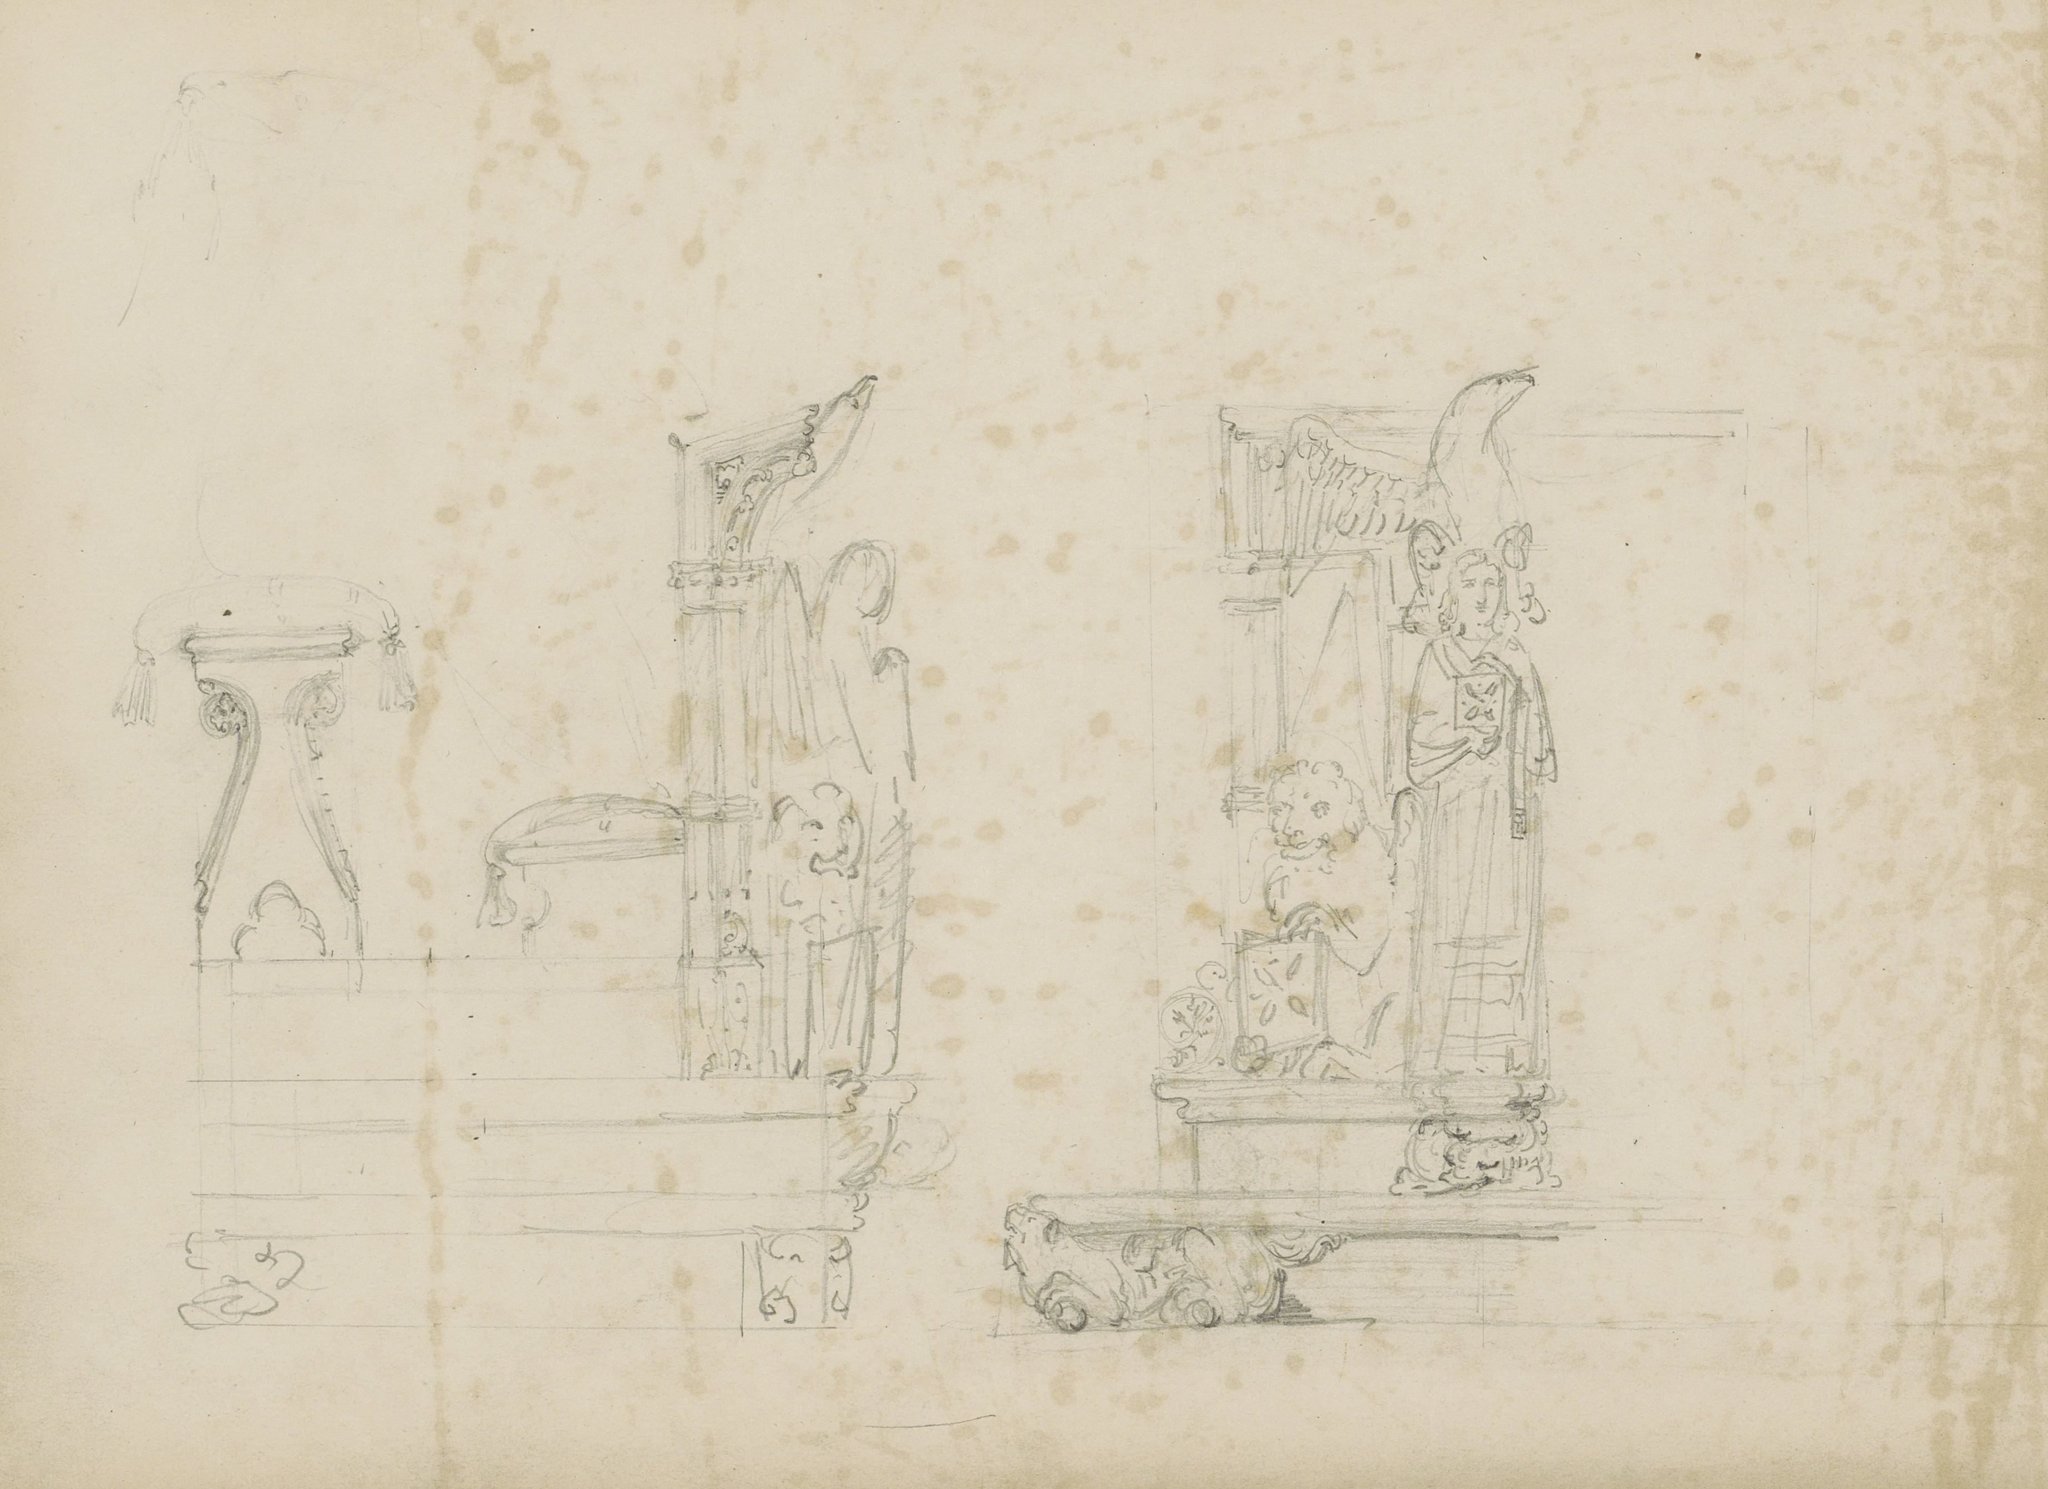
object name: sketchbook leaf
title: Spreekgestoelte, Grave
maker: pierre joseph hubert cuypers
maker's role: draughtsman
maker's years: 1827-1921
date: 1857-1859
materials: paper, pencil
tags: lectern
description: Titel gebaseerd op inhoudsopgave door Cuypers op blad 77 recto.